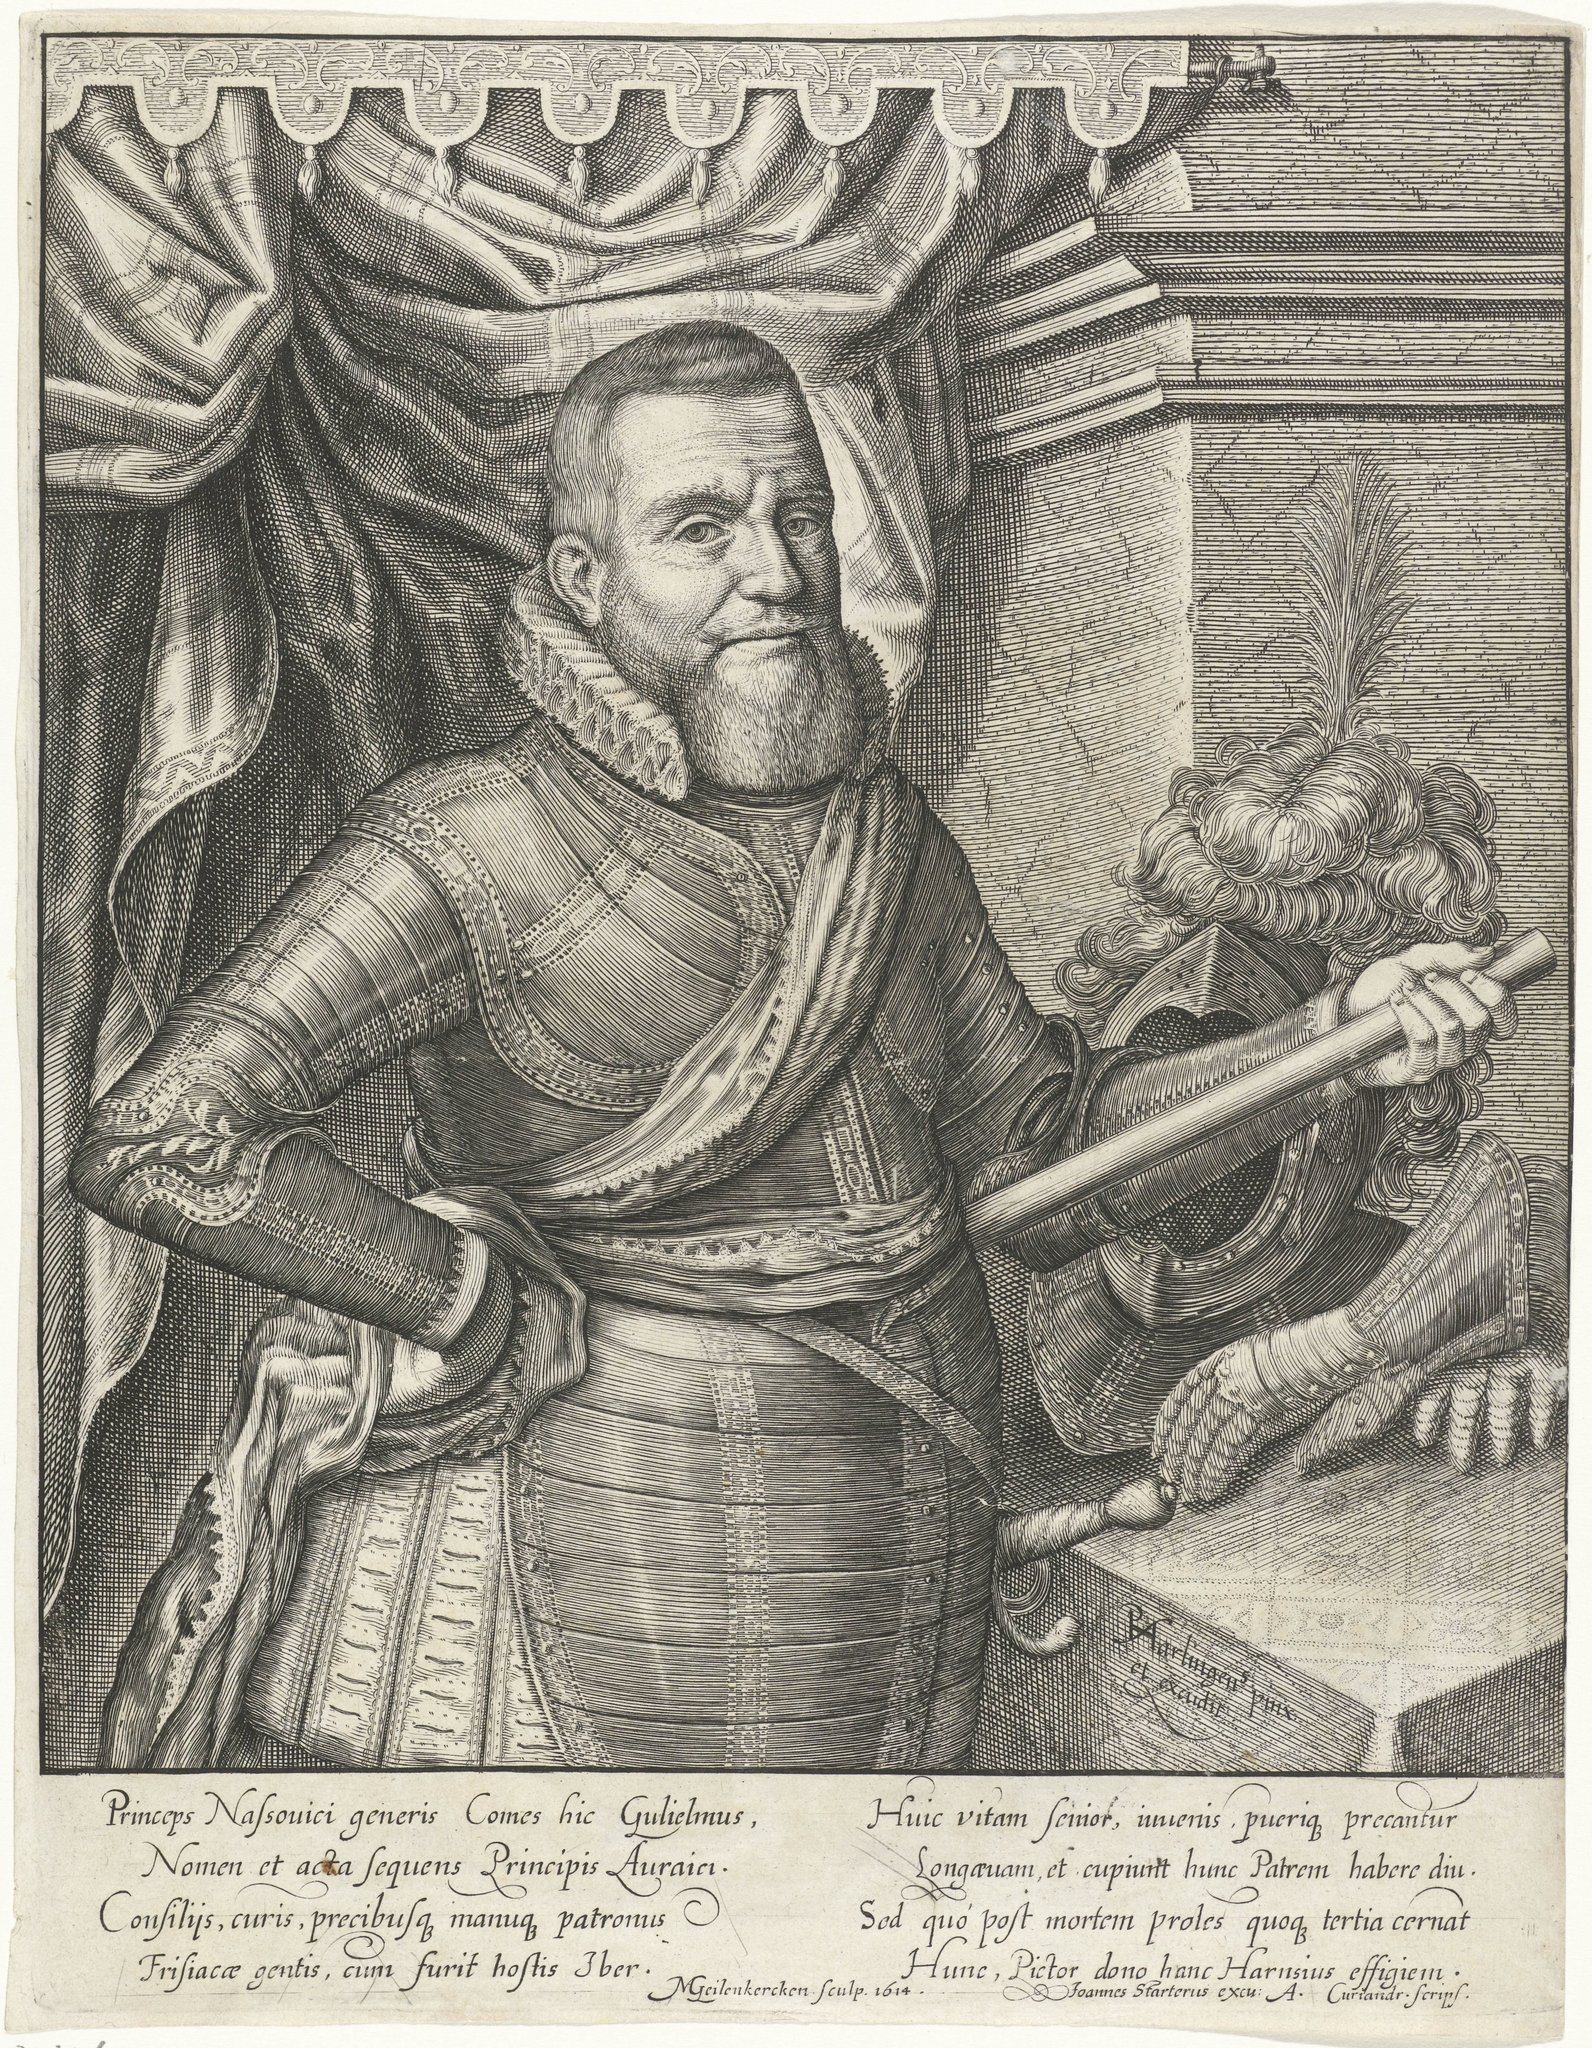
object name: print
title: Portret van Willem Lodewijk, stadhouder van Friesland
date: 1614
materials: paper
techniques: engraving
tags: willem lodewijk graaf van nassau-dillenburg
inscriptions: collector's mark: Lugt 2760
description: Portret van Willem Lodewijk van Nassau, stadshouder van Friesland. In wapenrusting, staand, ten halven lijve. Buste naar links. De prent heeft een Latijns onderschrift.